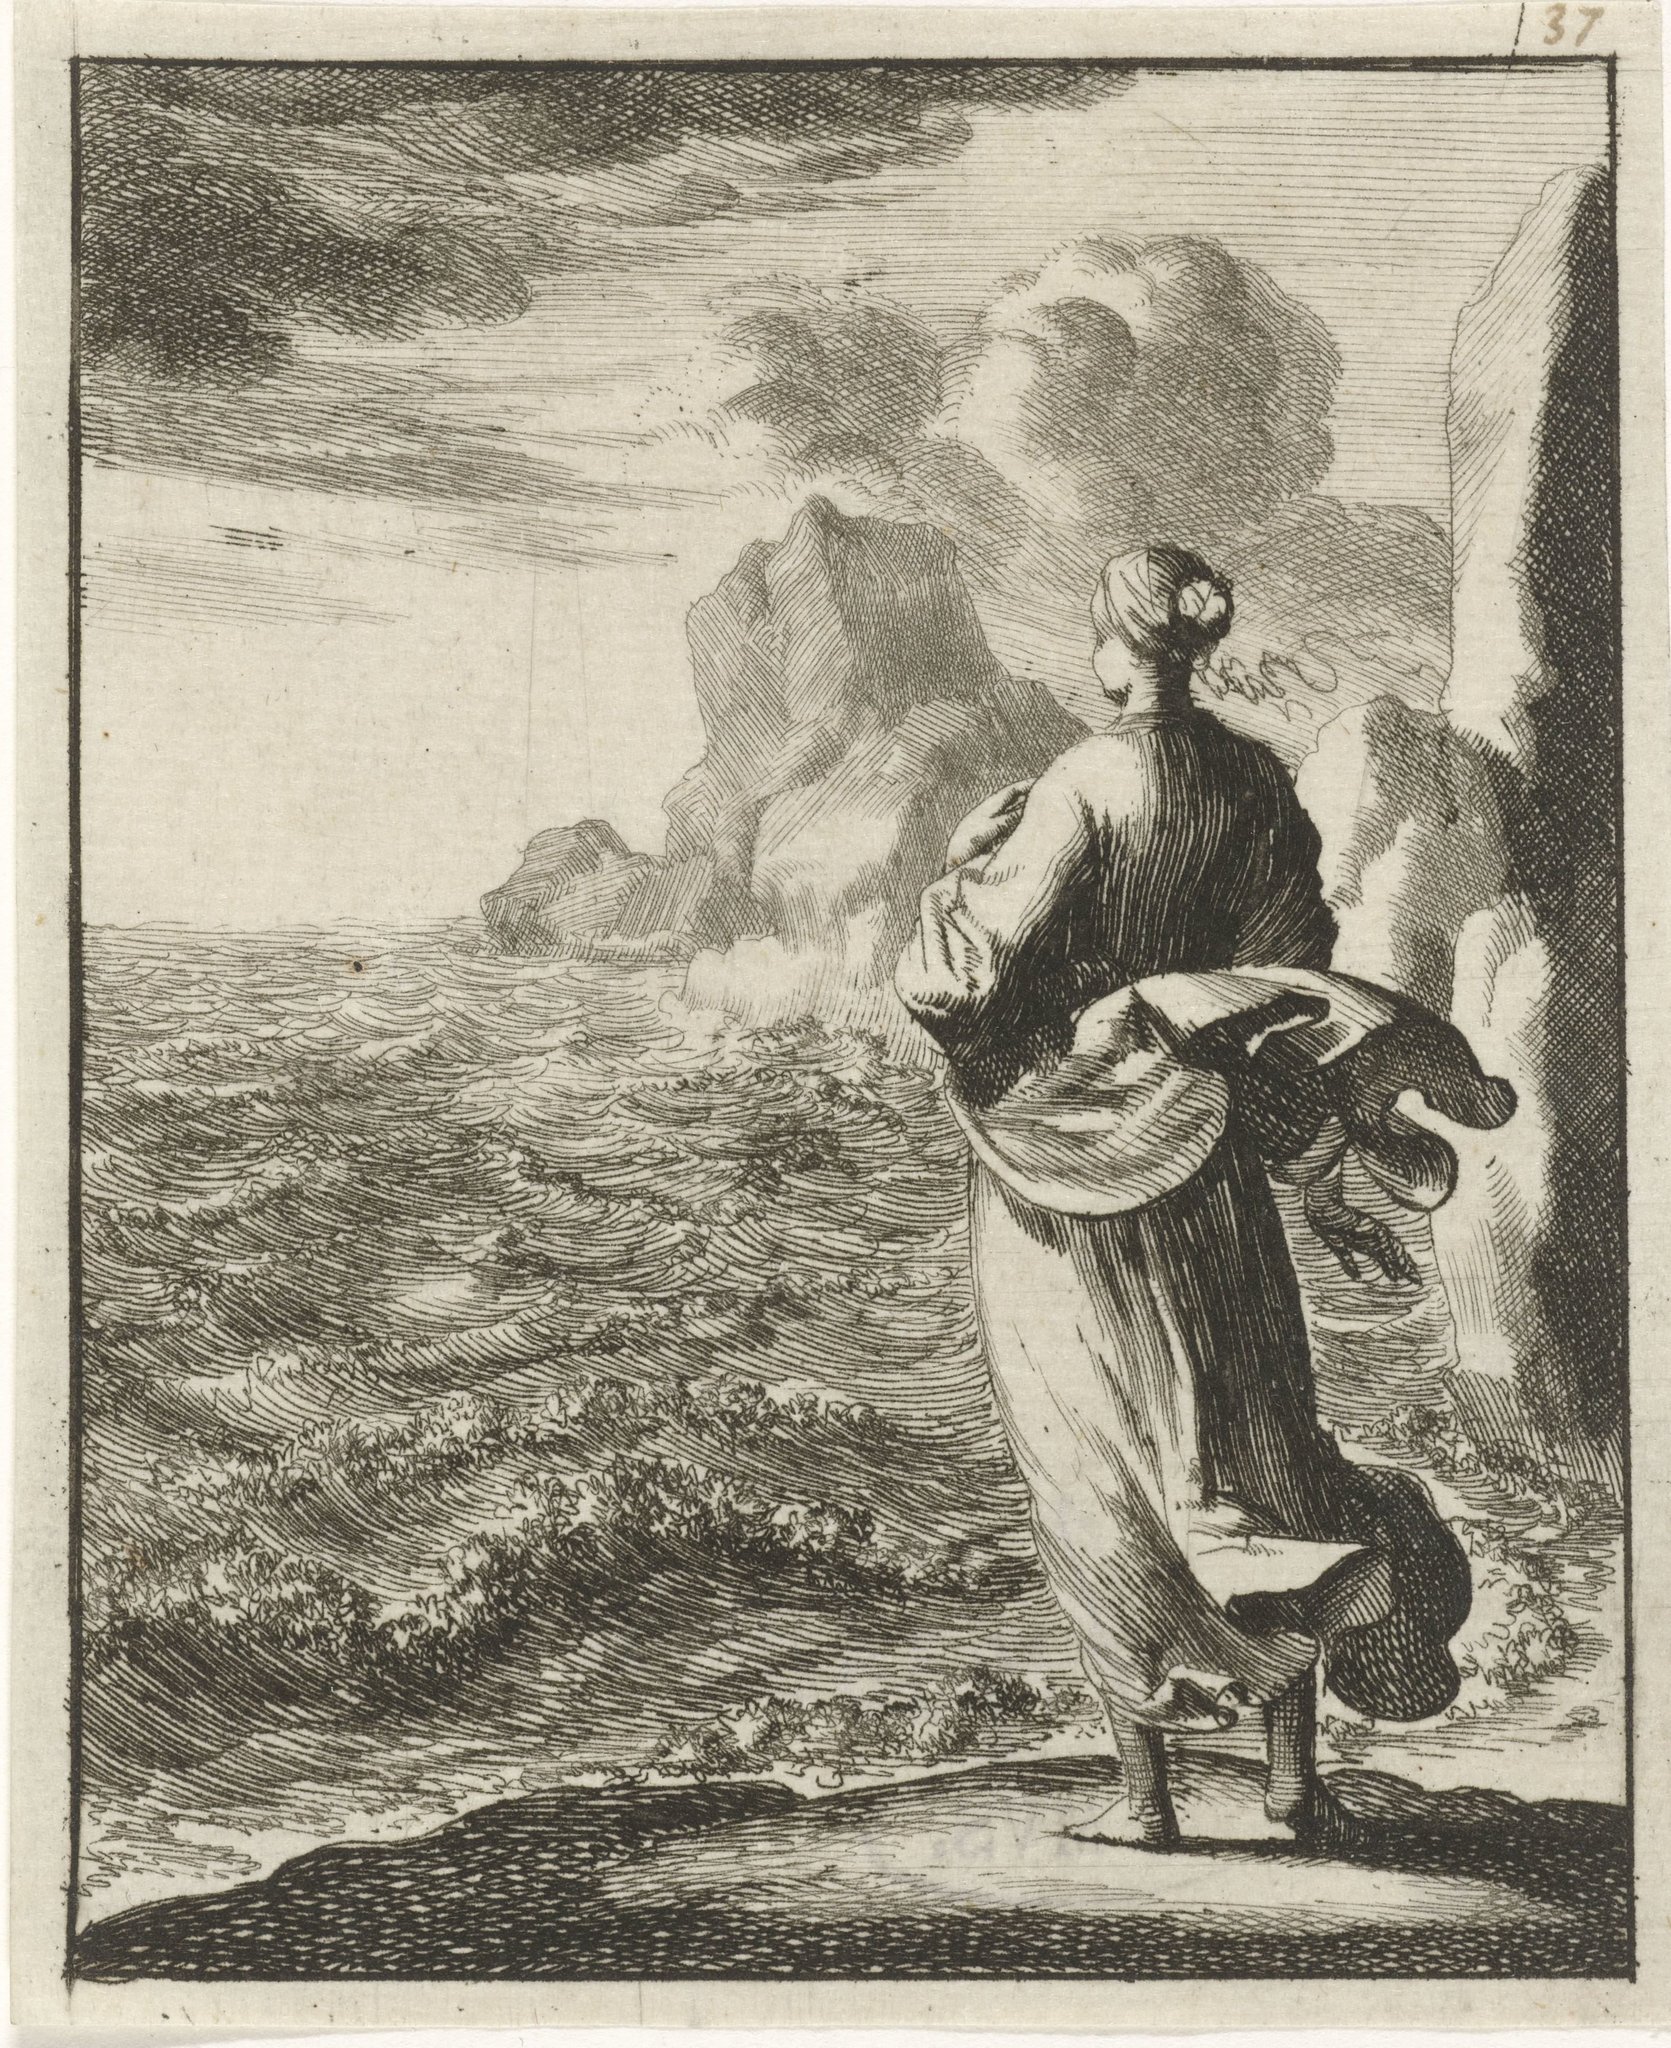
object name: book illustration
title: Vrouw kijkt vanaf de oever uit over zee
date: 1687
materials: paper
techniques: etching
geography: amsterdam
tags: sea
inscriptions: number: ‘37’, collector's mark: Lugt 2228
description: Illustratie uit: Luyken, Jan. Voncken der liefde Jesu, van het godtbegerende zielenvier. Amsterdam: Pieter Arentsz (II), 1687, p. 156